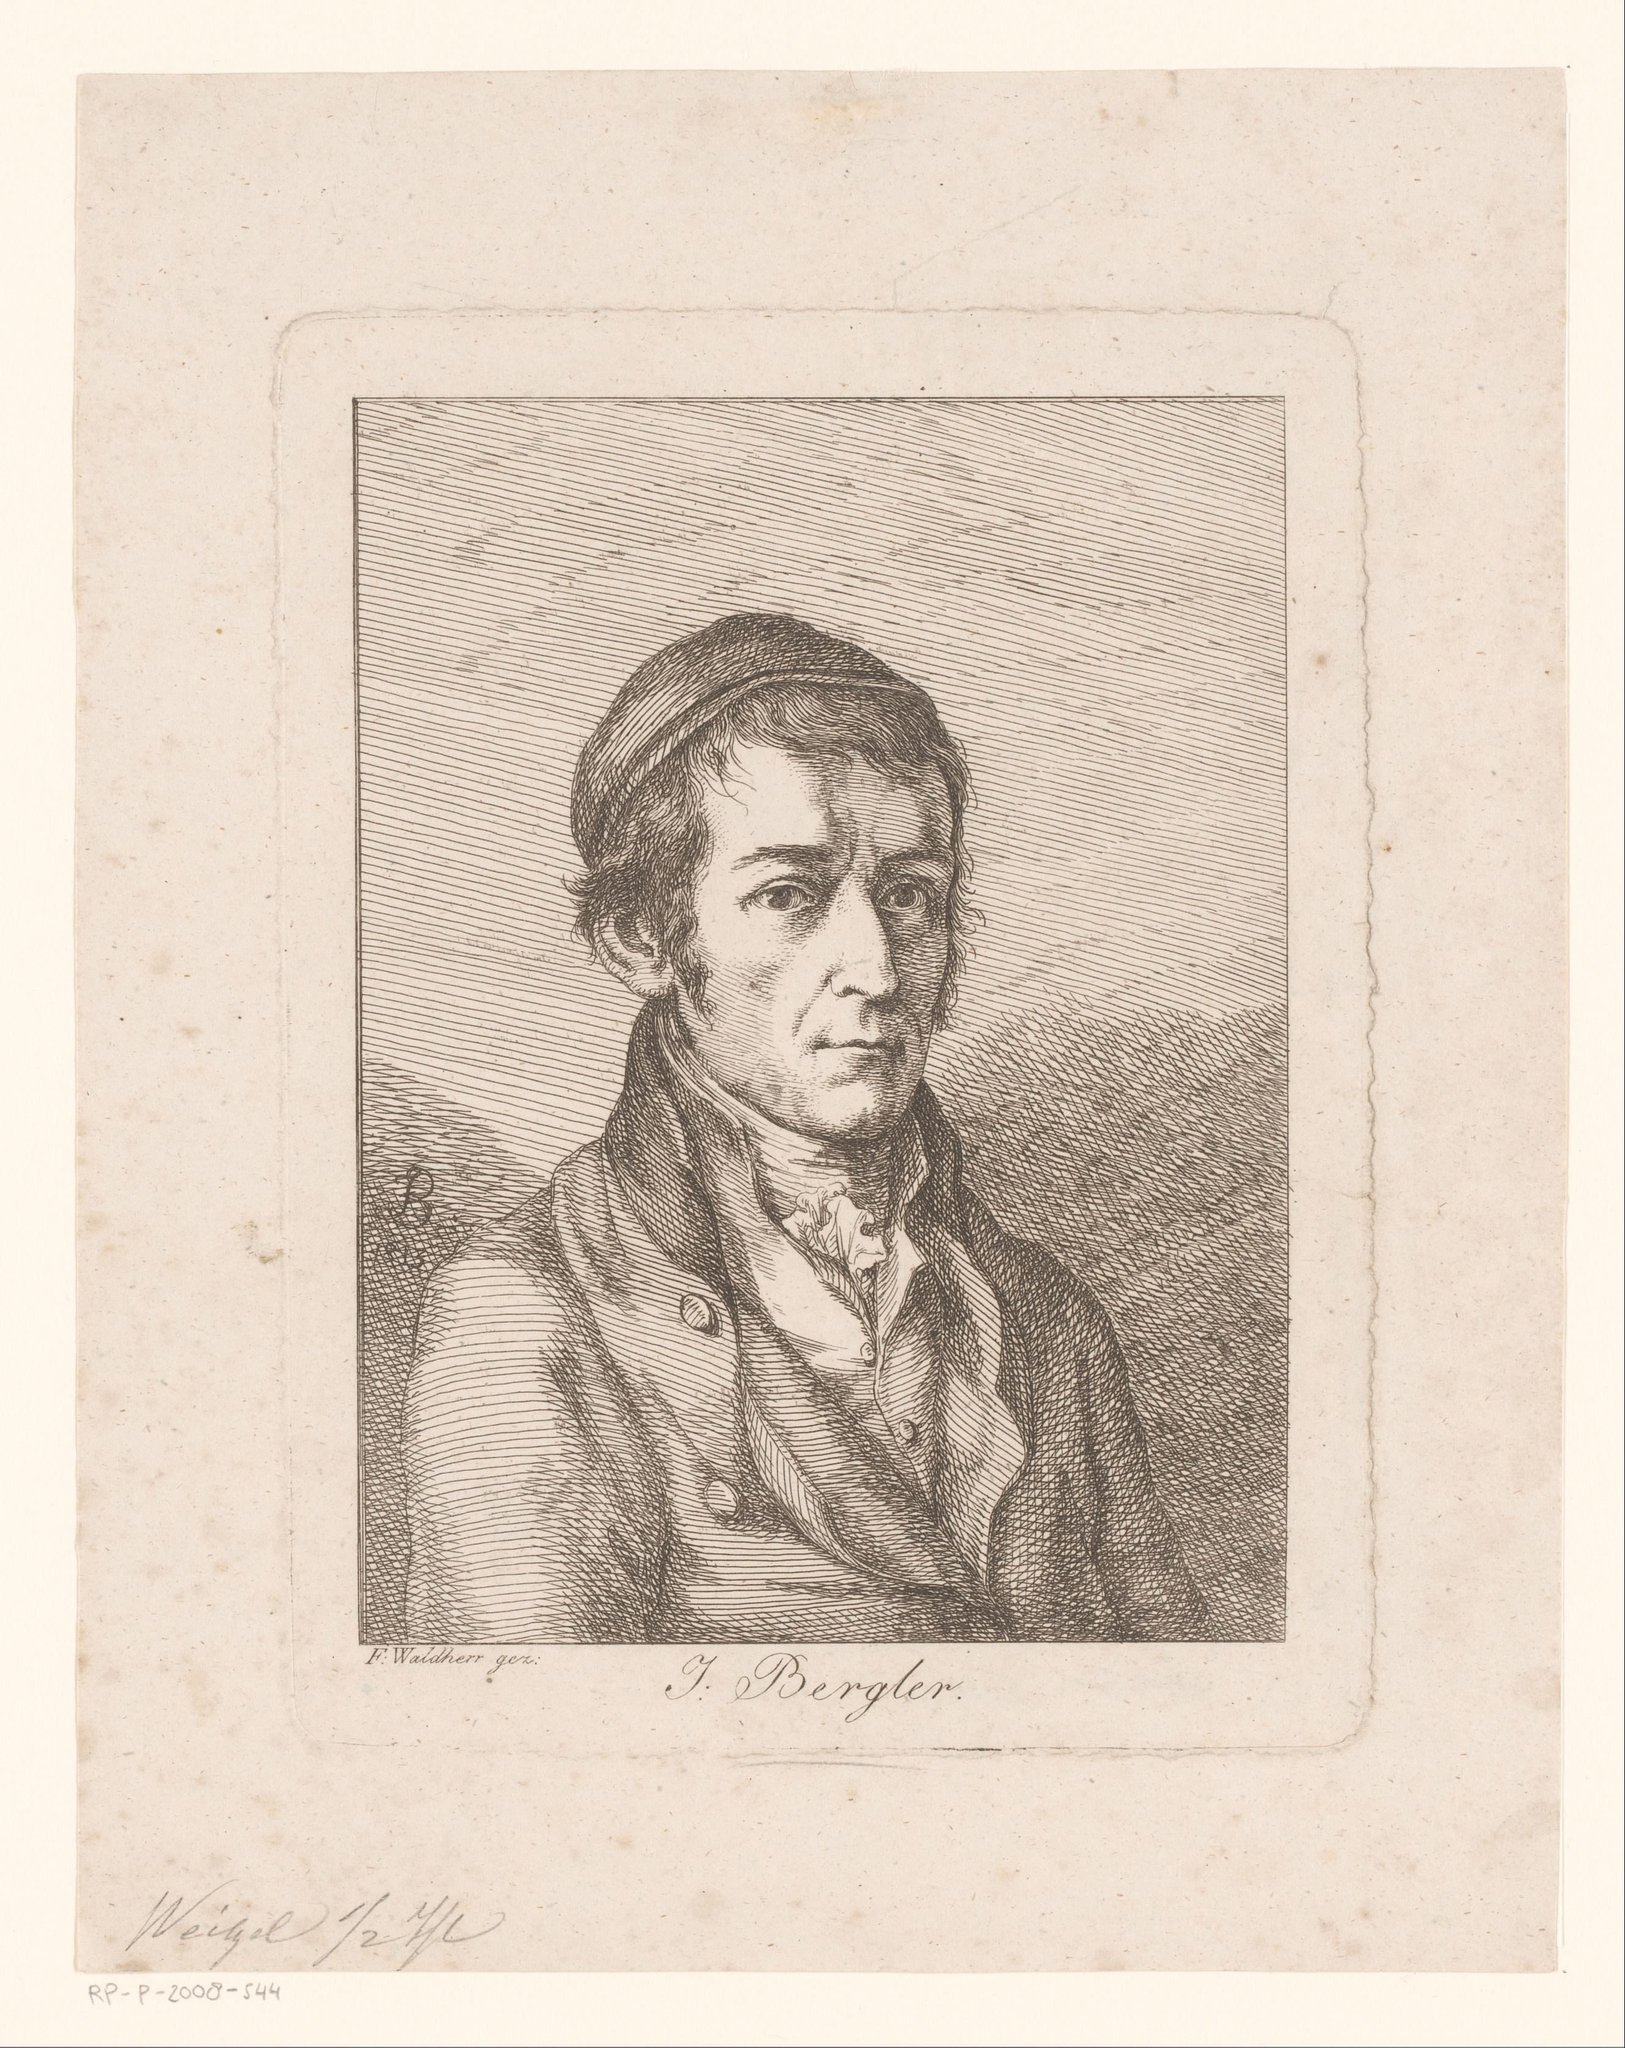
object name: print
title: Portret van Joseph Bergler II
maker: franz christian waldherr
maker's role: painter, print maker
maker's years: 1784-1835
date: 1813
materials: paper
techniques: etching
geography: germany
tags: prague, painter, print maker, joseph bergler (ii), historical persons, portrait, self-portrait of artist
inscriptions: collector's mark: Lugt 2760, collector's mark: Lugt 2228